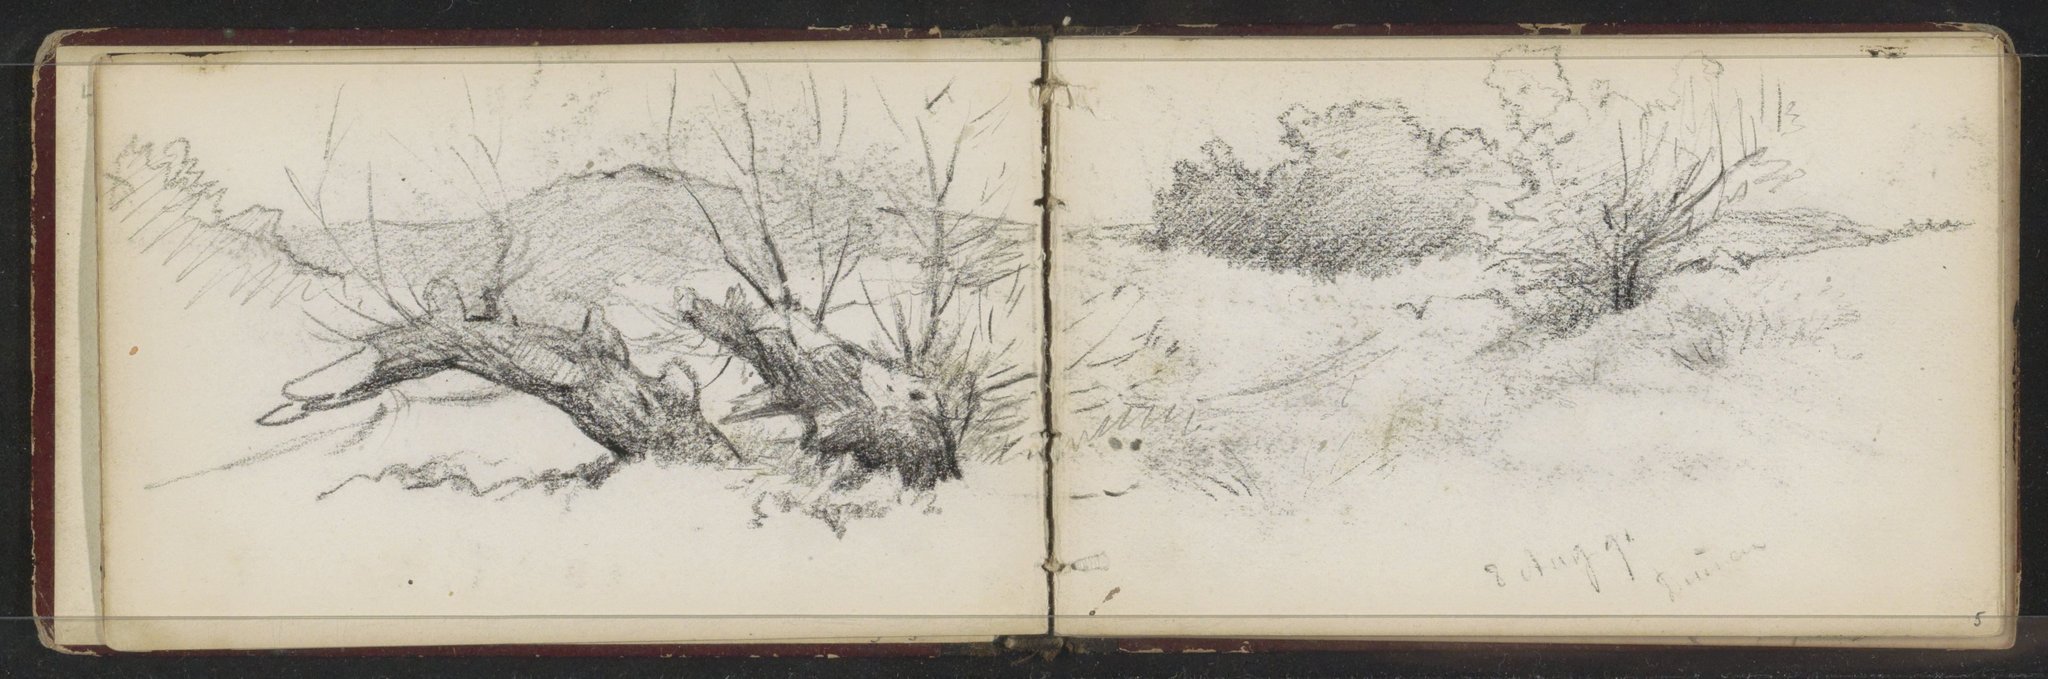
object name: sketchbook leaf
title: Duinen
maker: willem cornelis rip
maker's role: draughtsman, painter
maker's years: 1856-1922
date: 1808-1891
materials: chalk, paper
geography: scheveningen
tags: dunes (sea not visible); in the dunes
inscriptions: date and inscription: ‘8 Aug 91/ Duinen’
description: Blad 4 verso en 5 recto uit een schetsboek met 28 bladen.